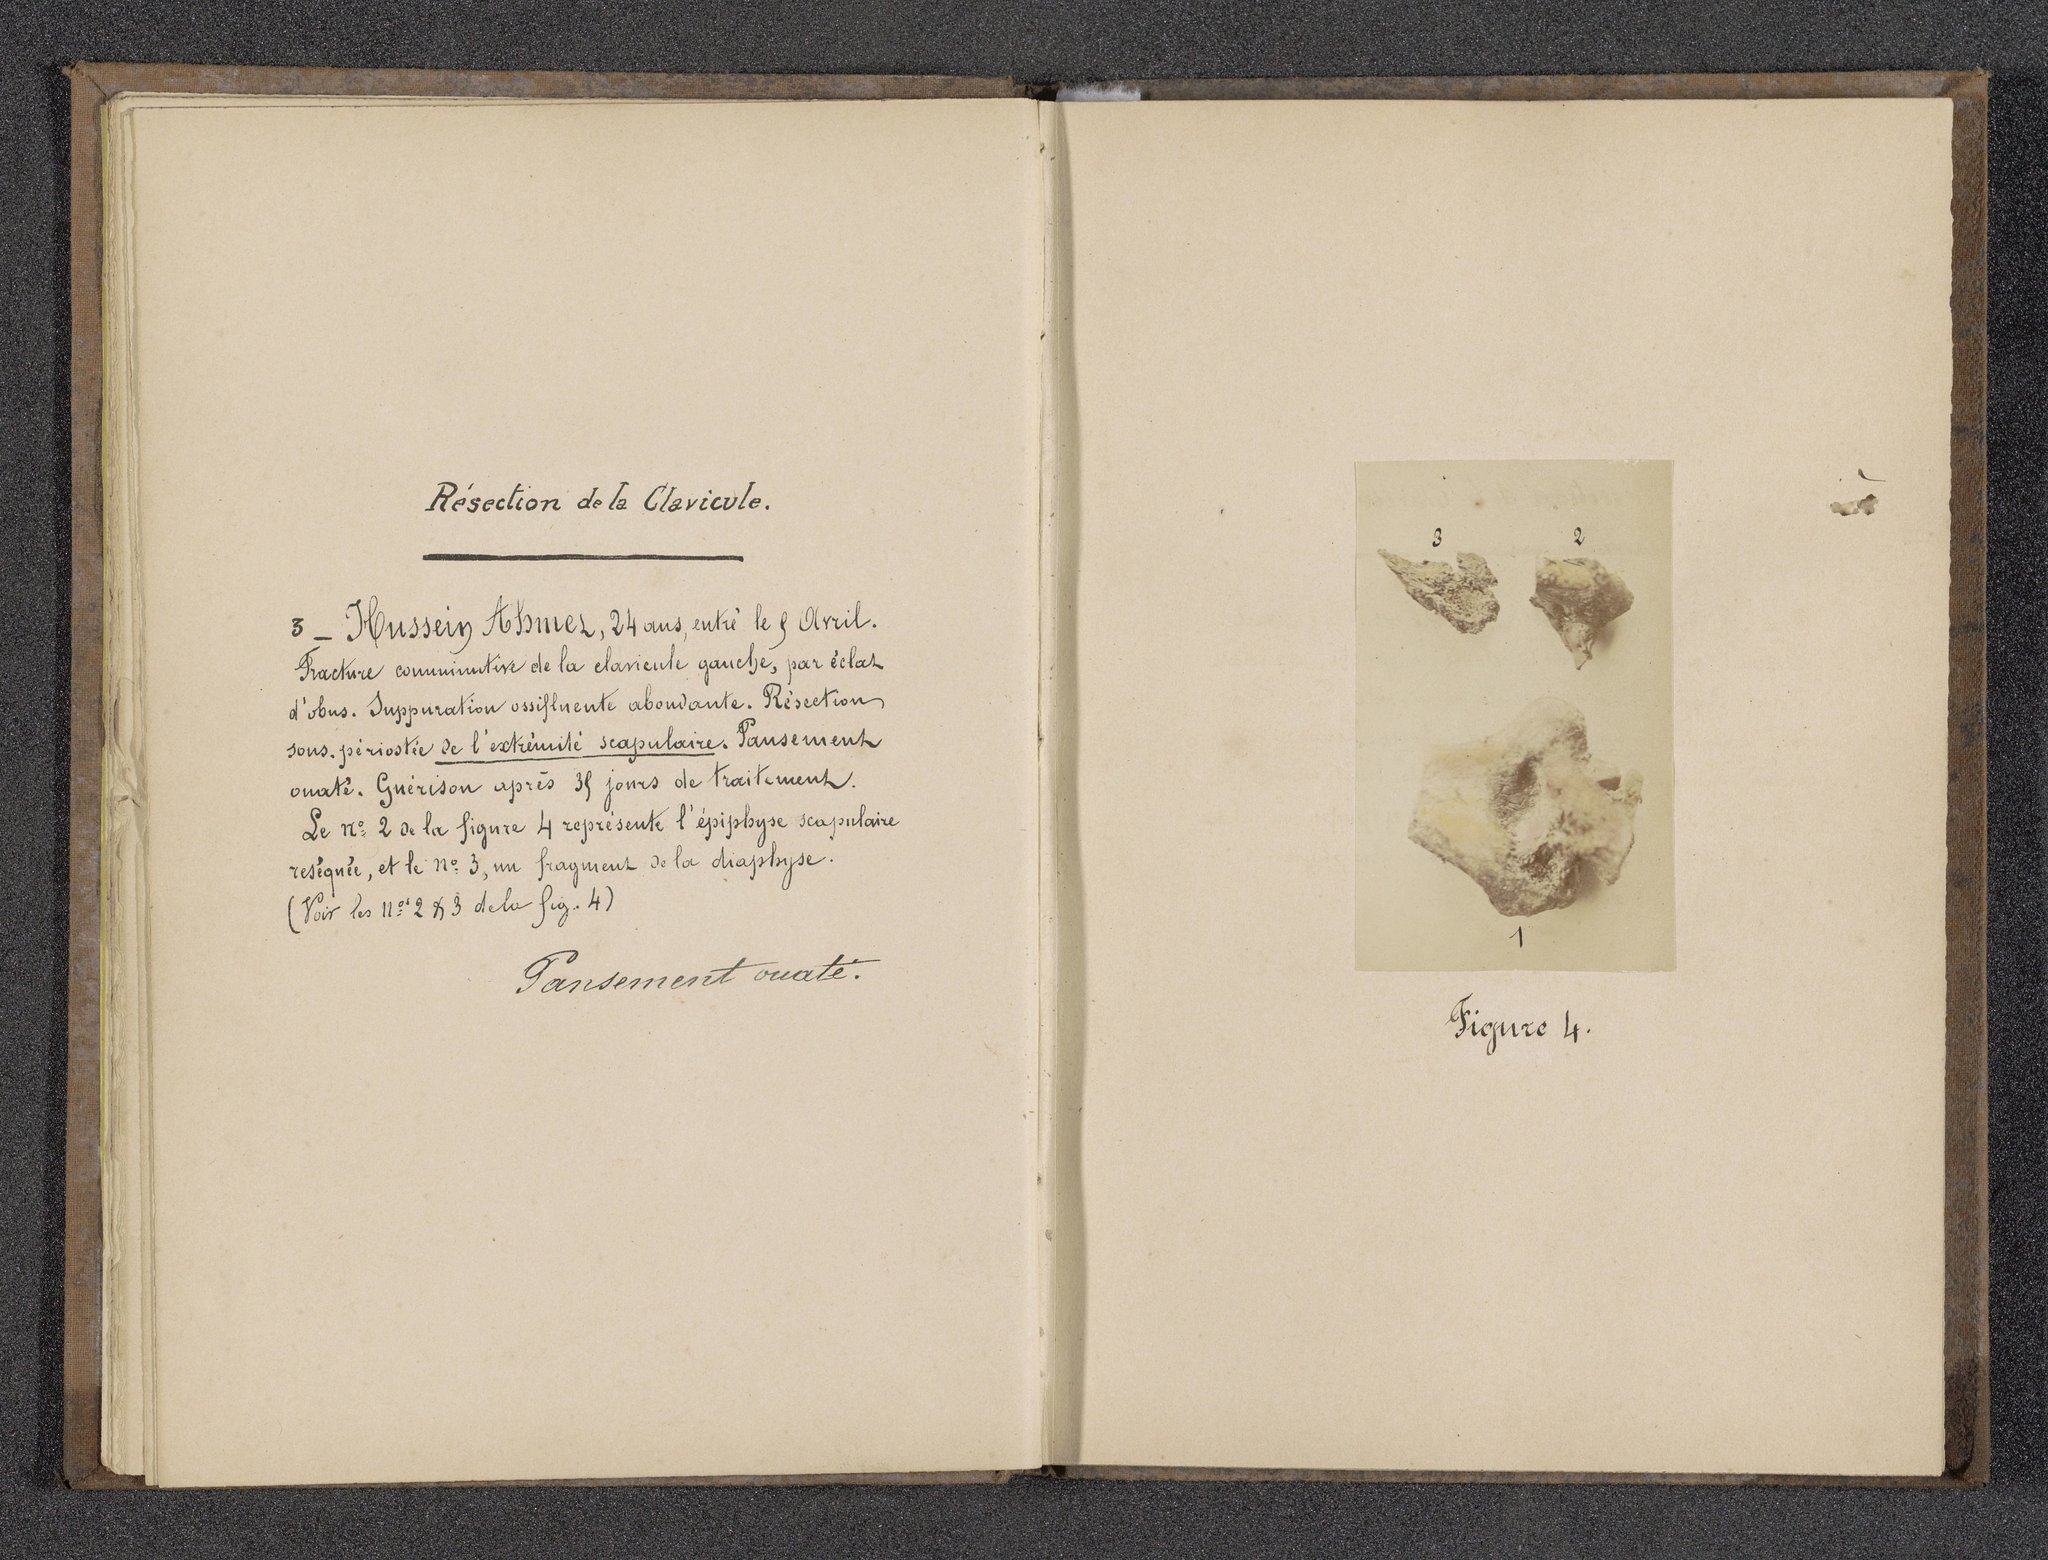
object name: photograph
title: Drie delen van een schouderblad na een operatie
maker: Anonymous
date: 1878-1880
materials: photographic support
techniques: albumen print, hand coloring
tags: scapula, shoulder-blade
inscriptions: number: ‘1, 2, 3’, number: ‘Figure 4.’